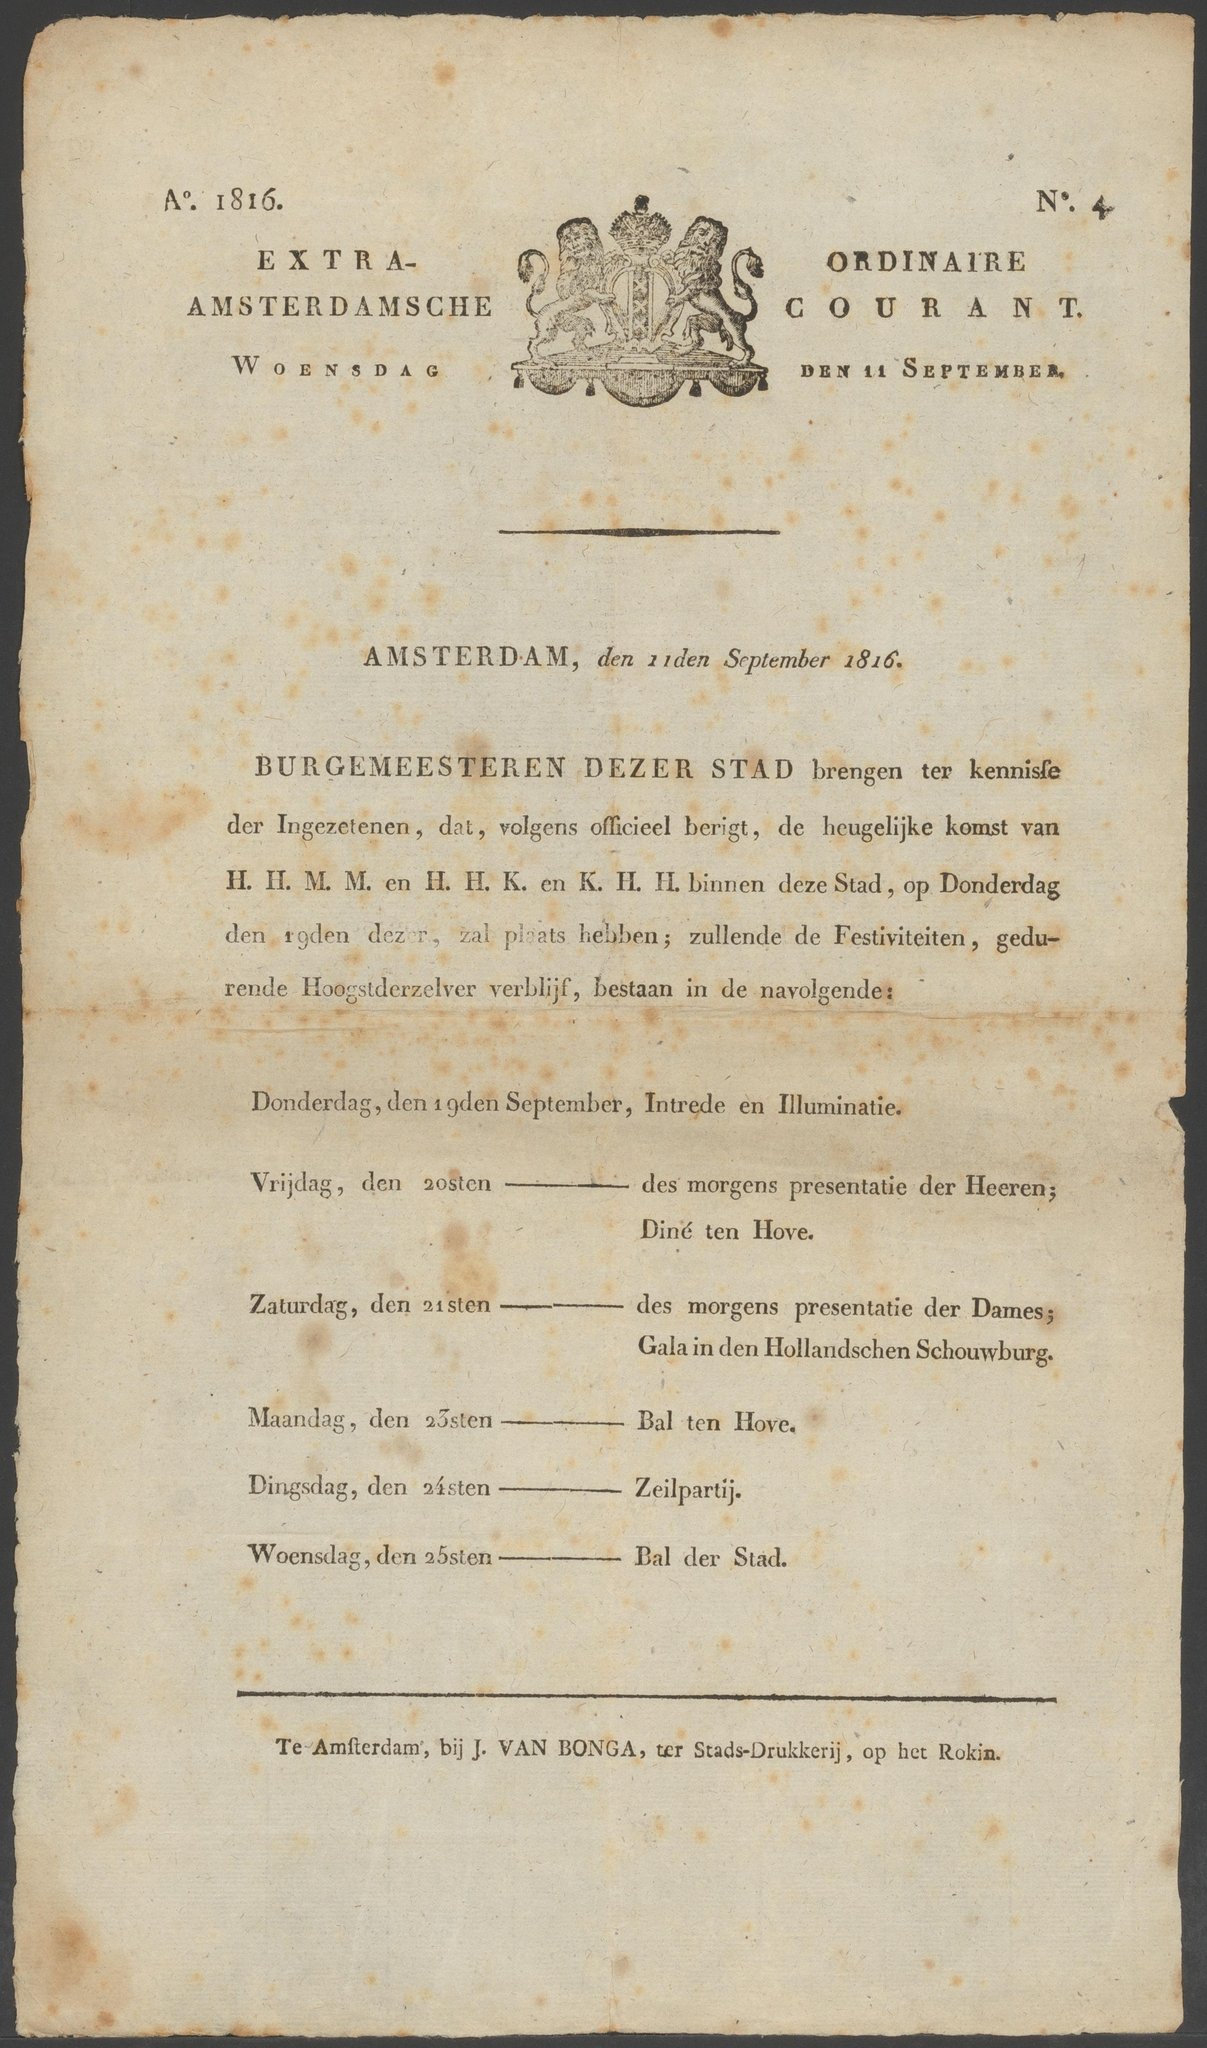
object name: newspaper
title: Extra-Ordinaire Amsterdamsche Courant, 11 september 1816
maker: jacobus van bonga jr.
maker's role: printer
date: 1816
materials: paper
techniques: letterpress printing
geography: amsterdam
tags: newspaper, news-sheet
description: Exemplaar van de krant 'Extra-Ordinaire Amsterdamsche Courant' van 11 september 1816. Enkelbladig, één zijde bedrukt. Bovenaan een vignet met het stadswapen. Op de verso een stempel betaalde accijnzen. Onderwerpsrubrieken binnen de Atlas Zeden en Gewoonten: Regeering, Officieele Nieuwsbladen.